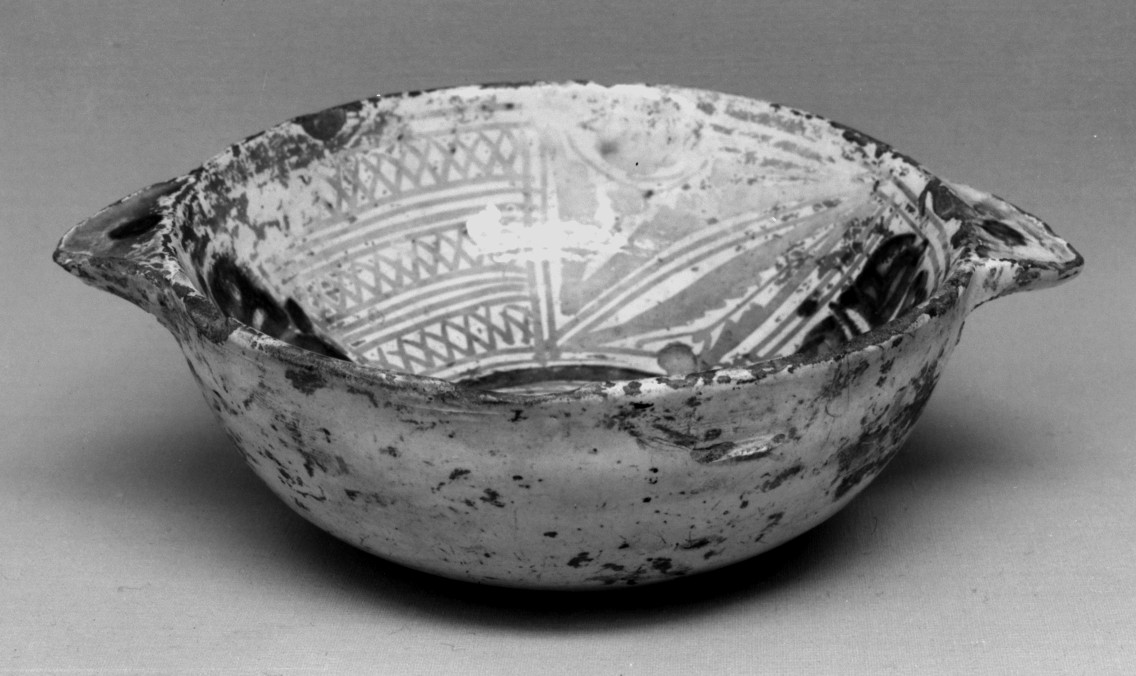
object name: scudella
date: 1451-1500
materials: earthenware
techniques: luster painting, glazing